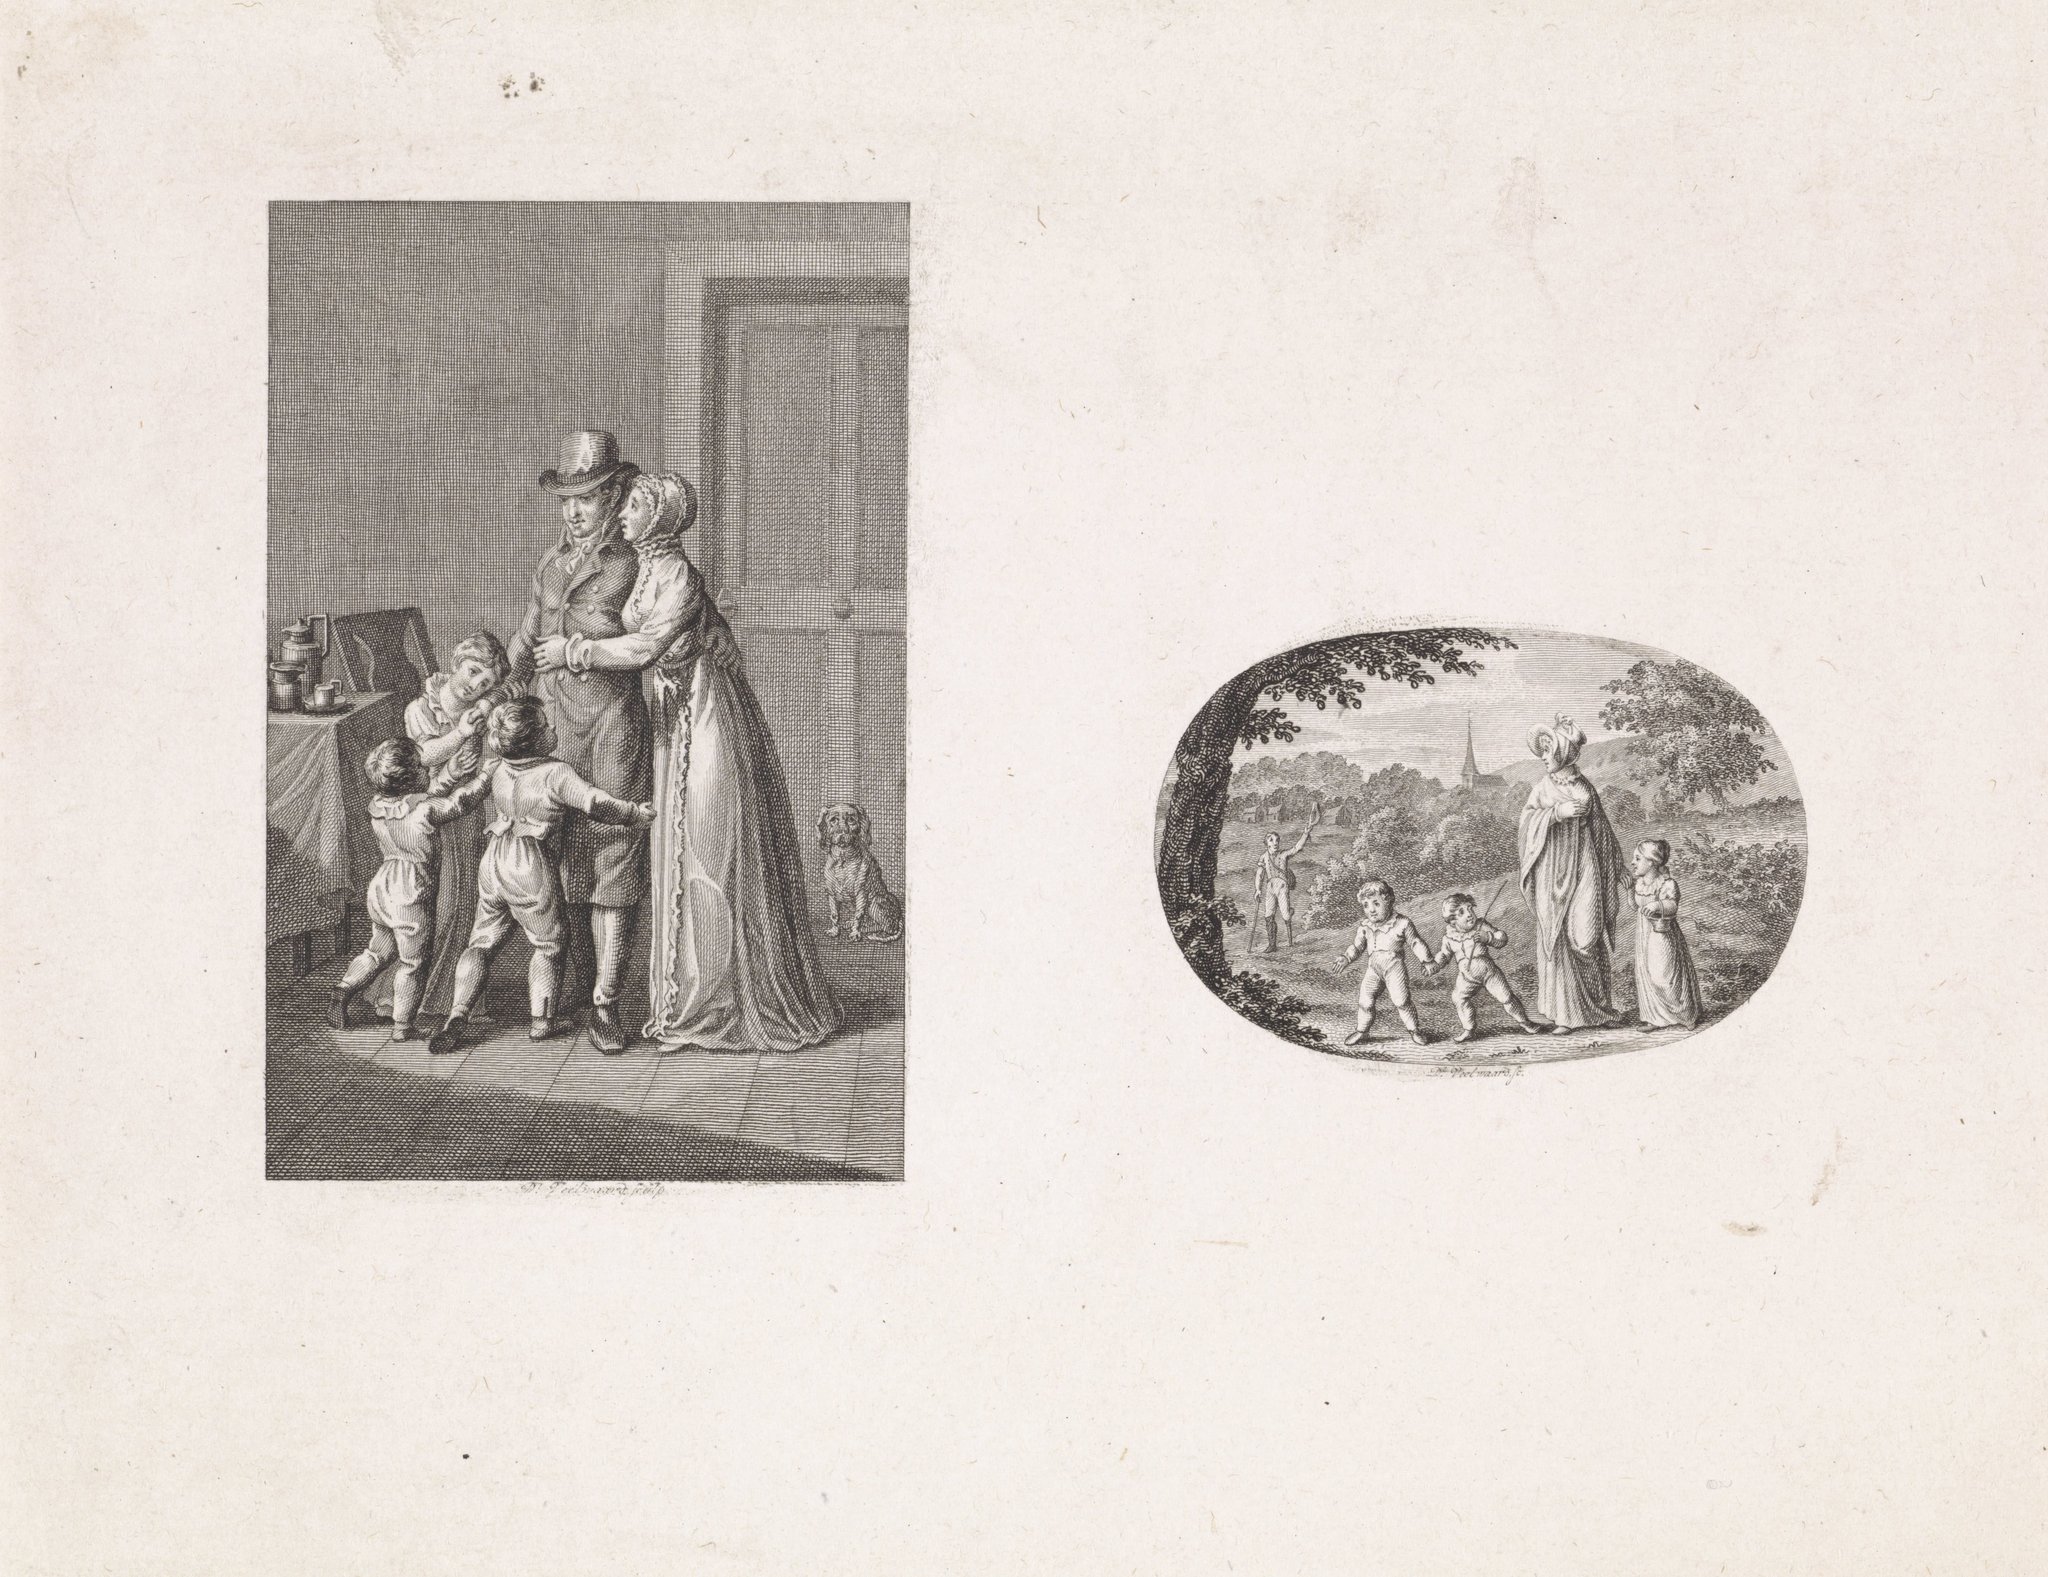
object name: print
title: Twee voorstellingen: Moeder en kinderen nemen afscheid van echtgenoot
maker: daniël veelwaard (i)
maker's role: print maker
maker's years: 1766-1851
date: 1776-1851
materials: paper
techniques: engraving, etching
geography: amsterdam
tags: embracing each other, kissing, waving farewell ~ departure on a journey, taking leave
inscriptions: collector's mark: Lugt 2228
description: Twee voorstellingen: Moeder en kinderen nemen afscheid van echtgenoot. Links wordt de man door de vrouw en kinderen omhelsd in een interieur. Rechts zwaait hij hen uit in een landschap, met op de achtergrond een kerktoren.